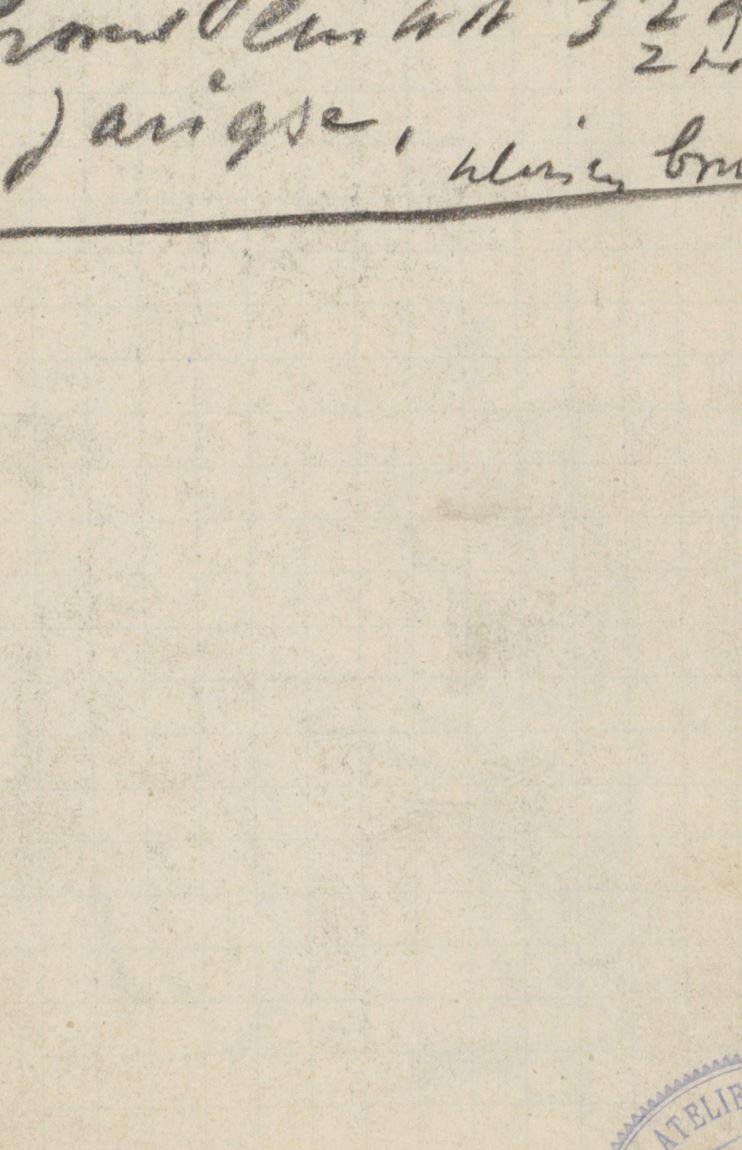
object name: sketchbook leaf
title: Annotaties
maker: george hendrik breitner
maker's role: draughtsman, painter, print maker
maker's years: 1857-1923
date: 1896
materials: chalk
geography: amsterdam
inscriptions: annotation:, workshop stamp: Lugt 291d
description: Pagina 14 uit een schetsboek met 20 bladen.